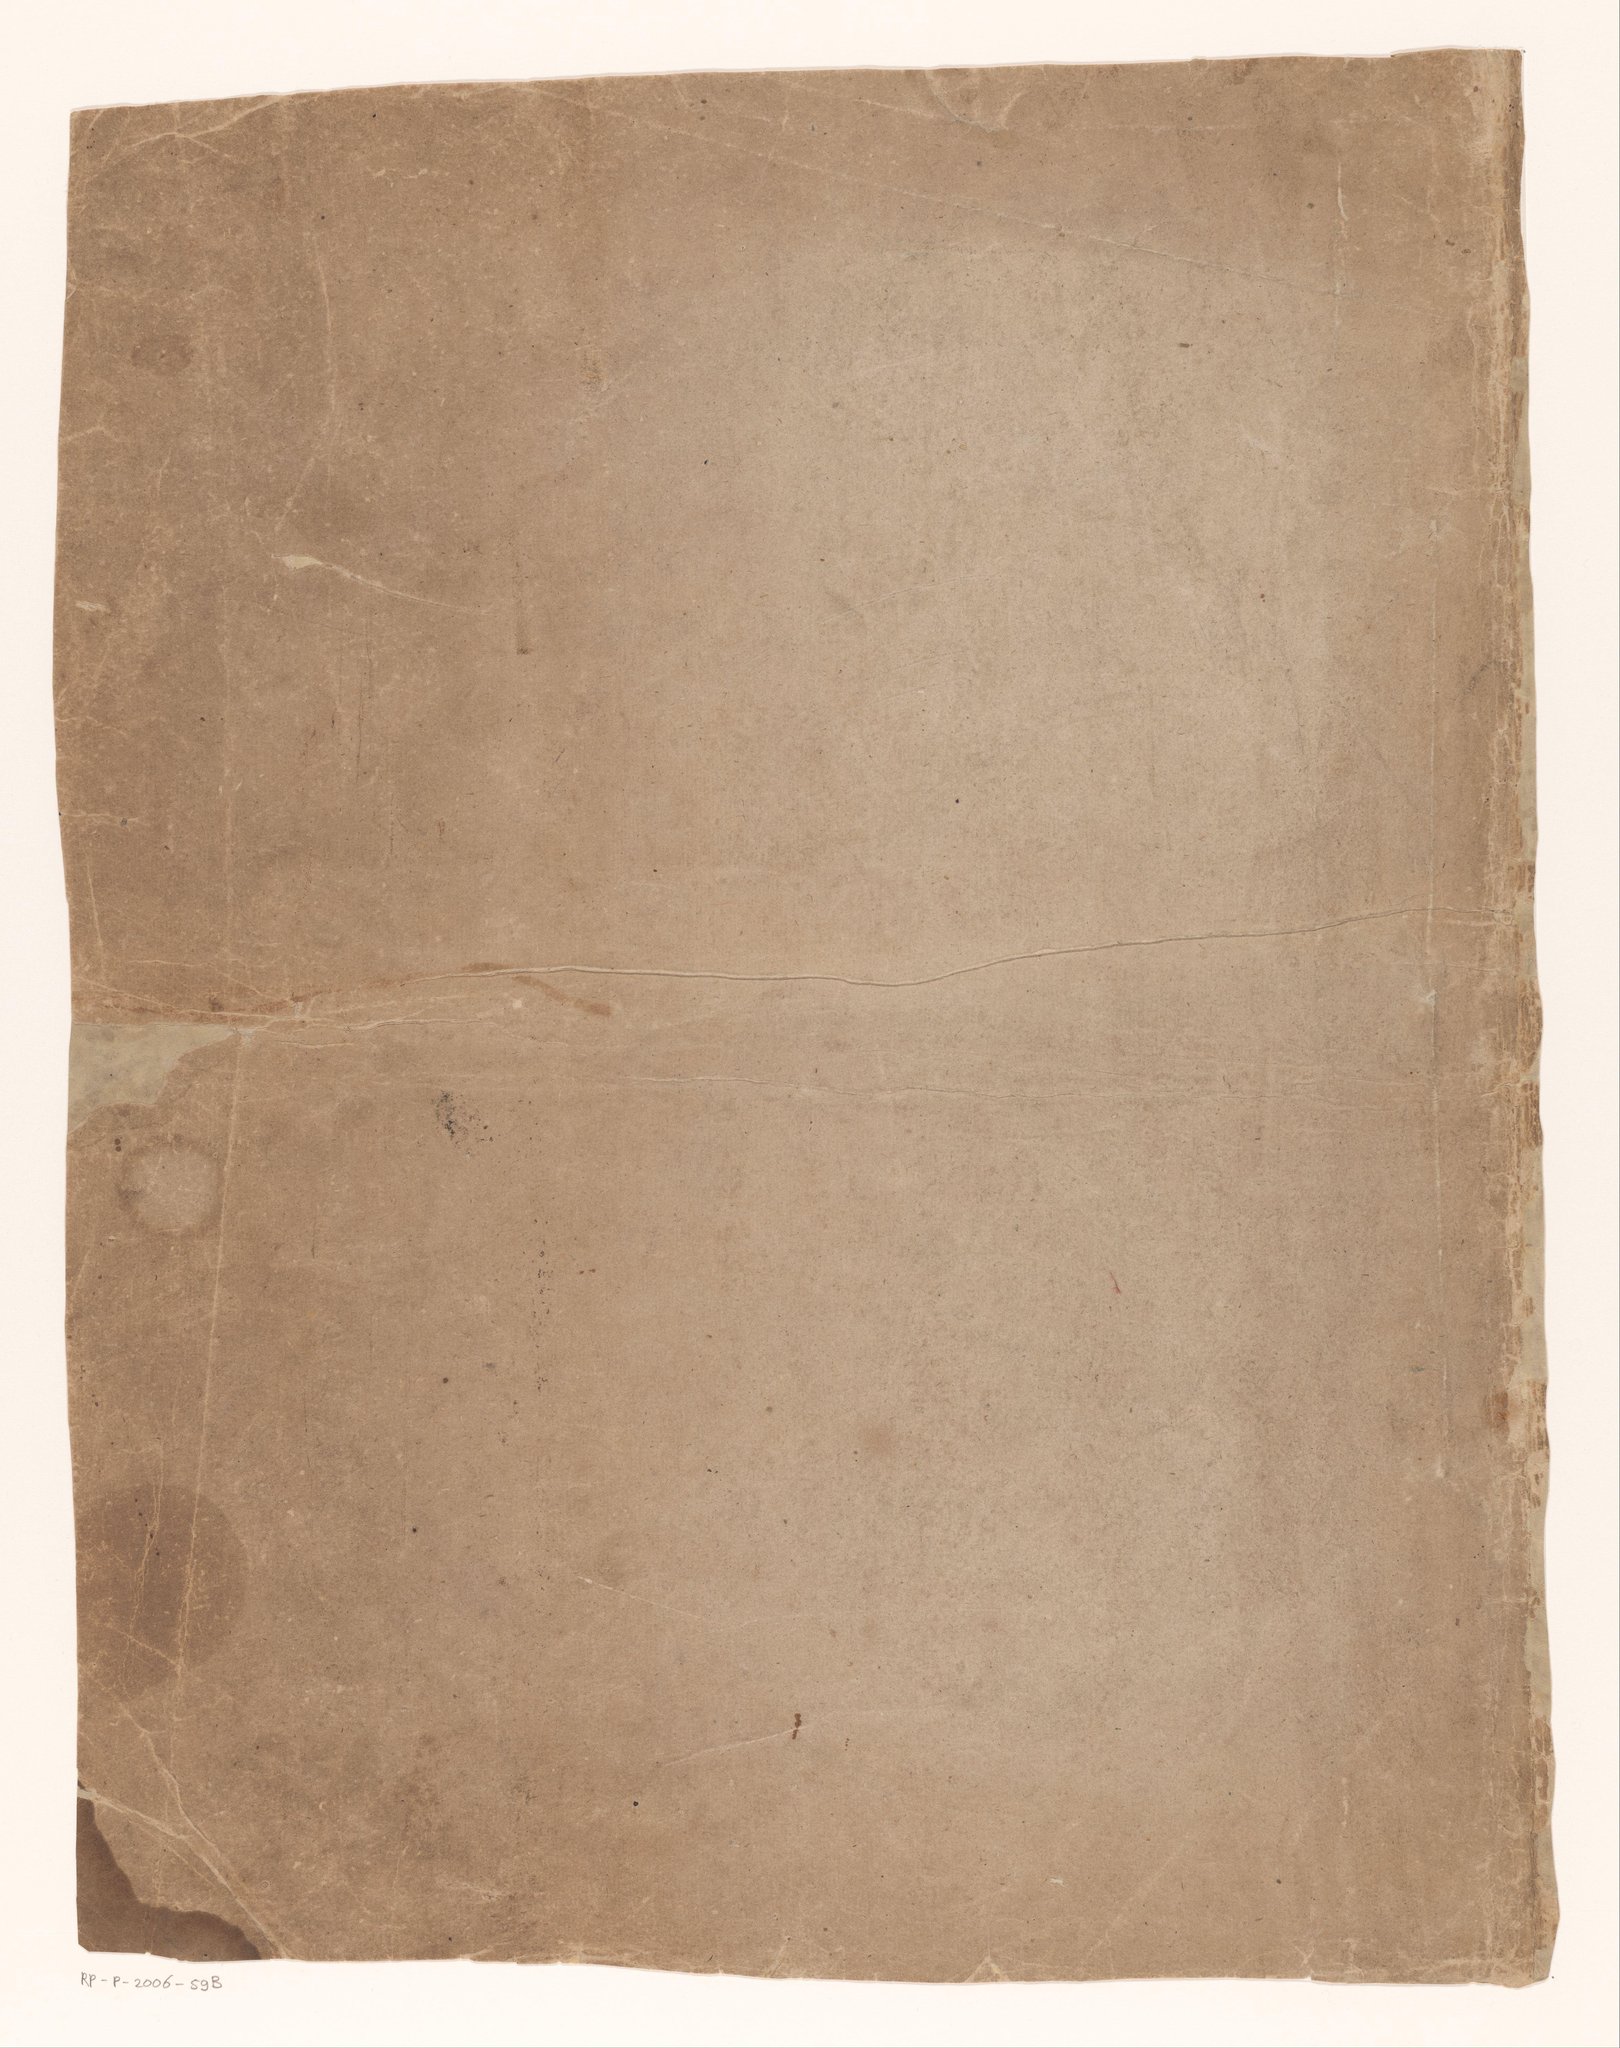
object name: wrapper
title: Omslag voor Livre des differentes éspeces d'oiseaux de la Chine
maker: gabriel huquier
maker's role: painter, print maker, publisher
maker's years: 1695-1772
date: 1742-1750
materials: paper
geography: paris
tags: book-cover, binding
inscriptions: collector's mark: Lugt 2228, collector's mark: Lugt 2760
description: Achterzijde van omslag voor prentenreeks Livre des differentes éspeces d'oiseaux de la Chine. Zonder gedrukte tekst.